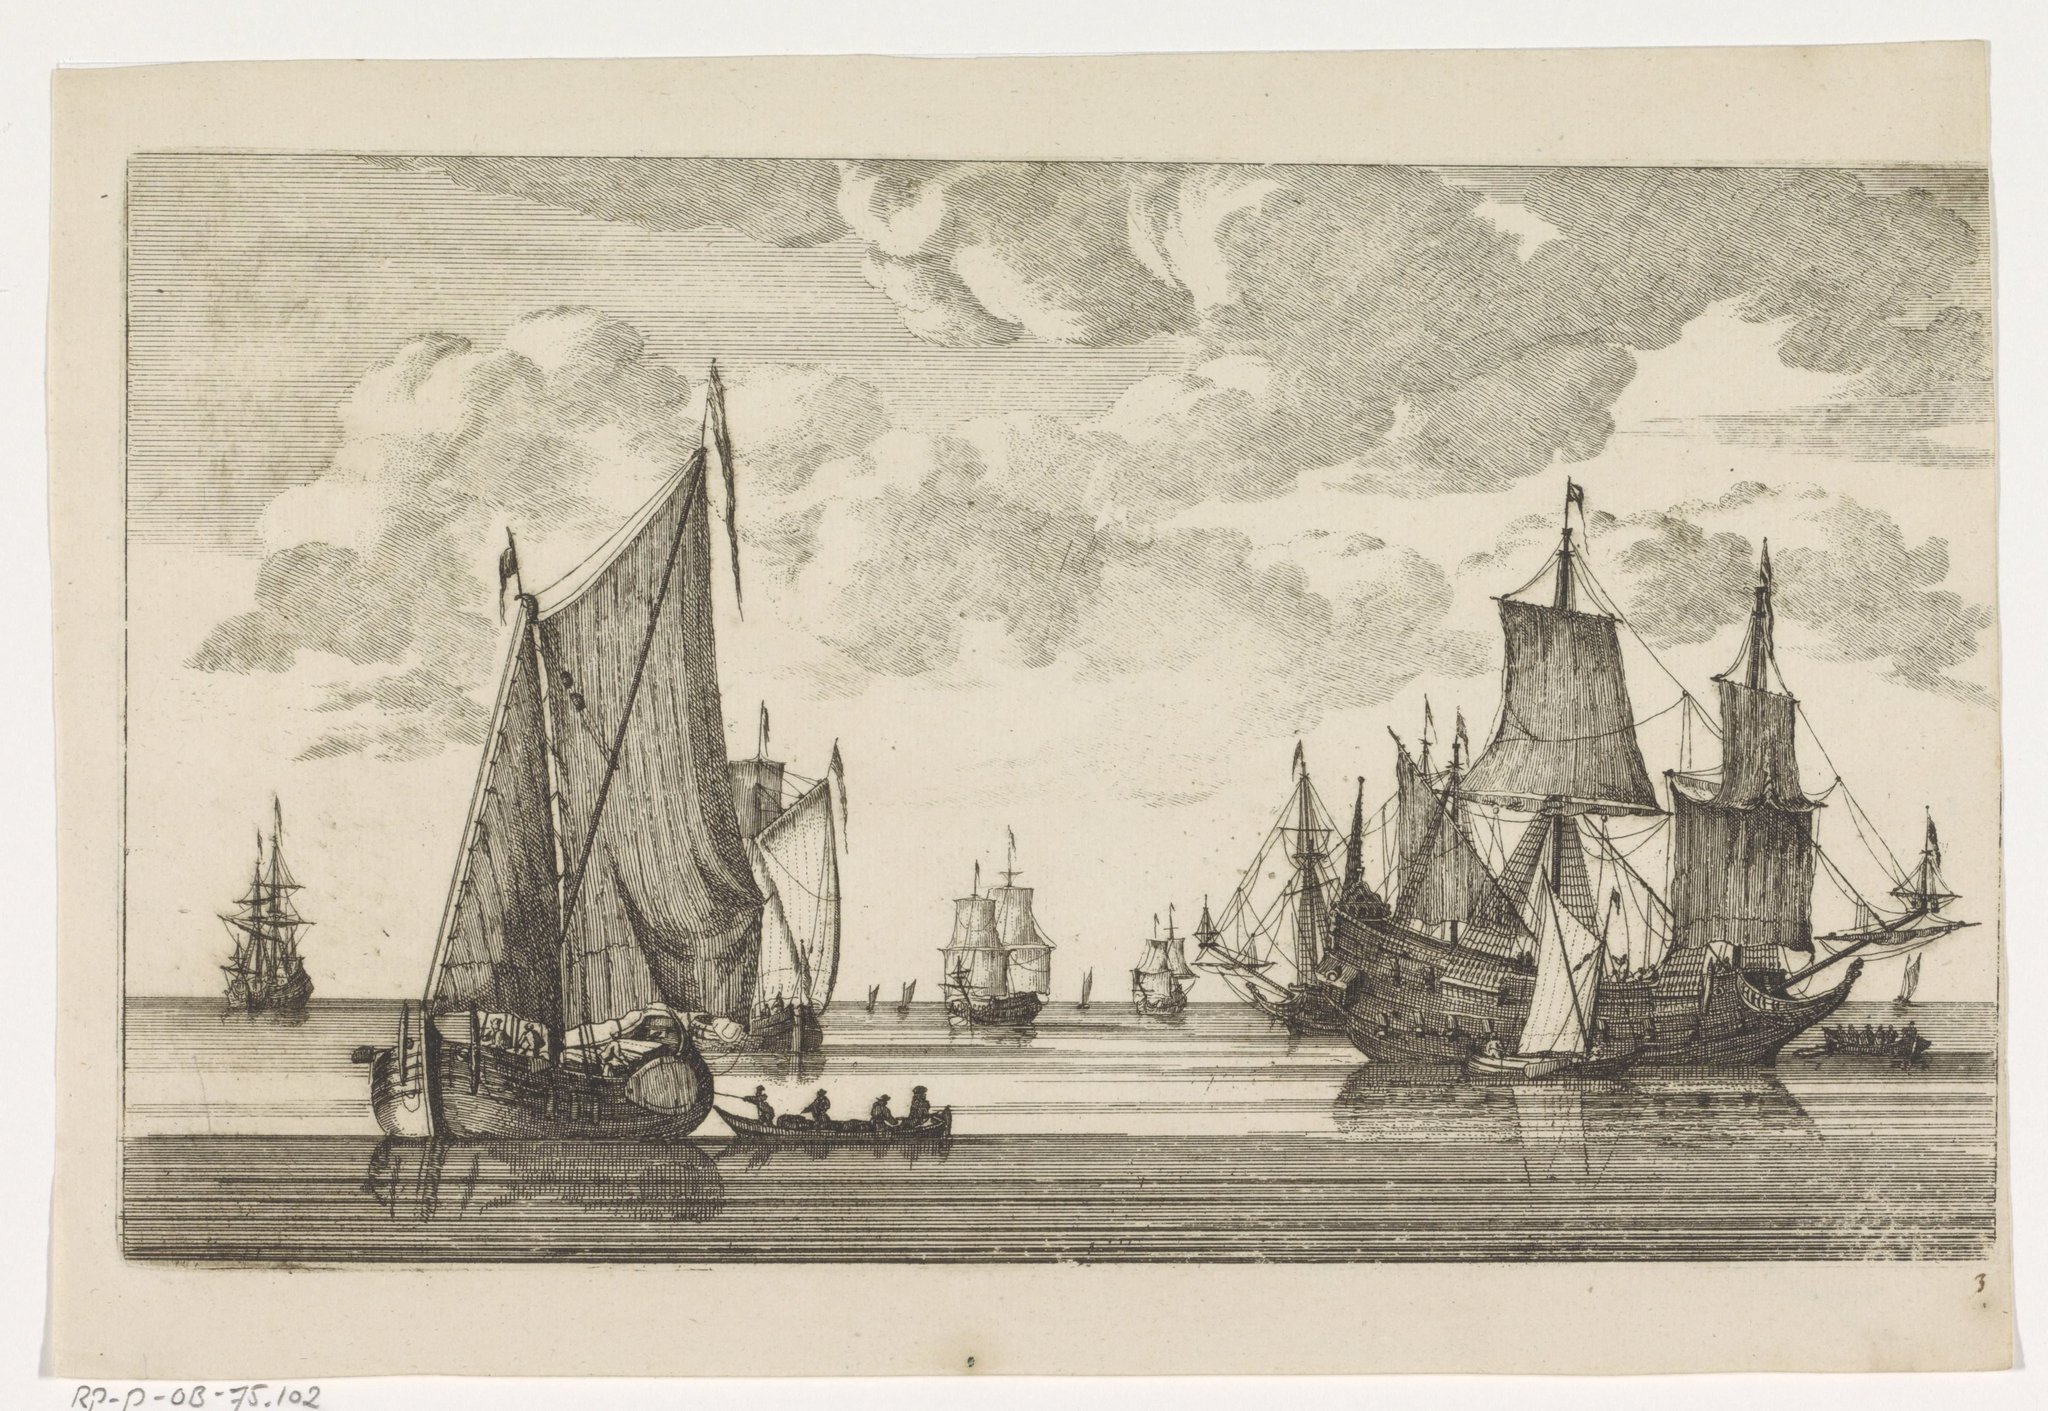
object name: print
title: Zeilschepen en sloepen op kalme zee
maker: Anonymous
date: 1600-1700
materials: paper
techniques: etching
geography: netherlands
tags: sailing-ship, sailing-boat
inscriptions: inscription: ‘FM 1884’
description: Links een zeilschip en sloep. Rechts een oorlogsschip met een klein zeilschip en een sloep langszij.